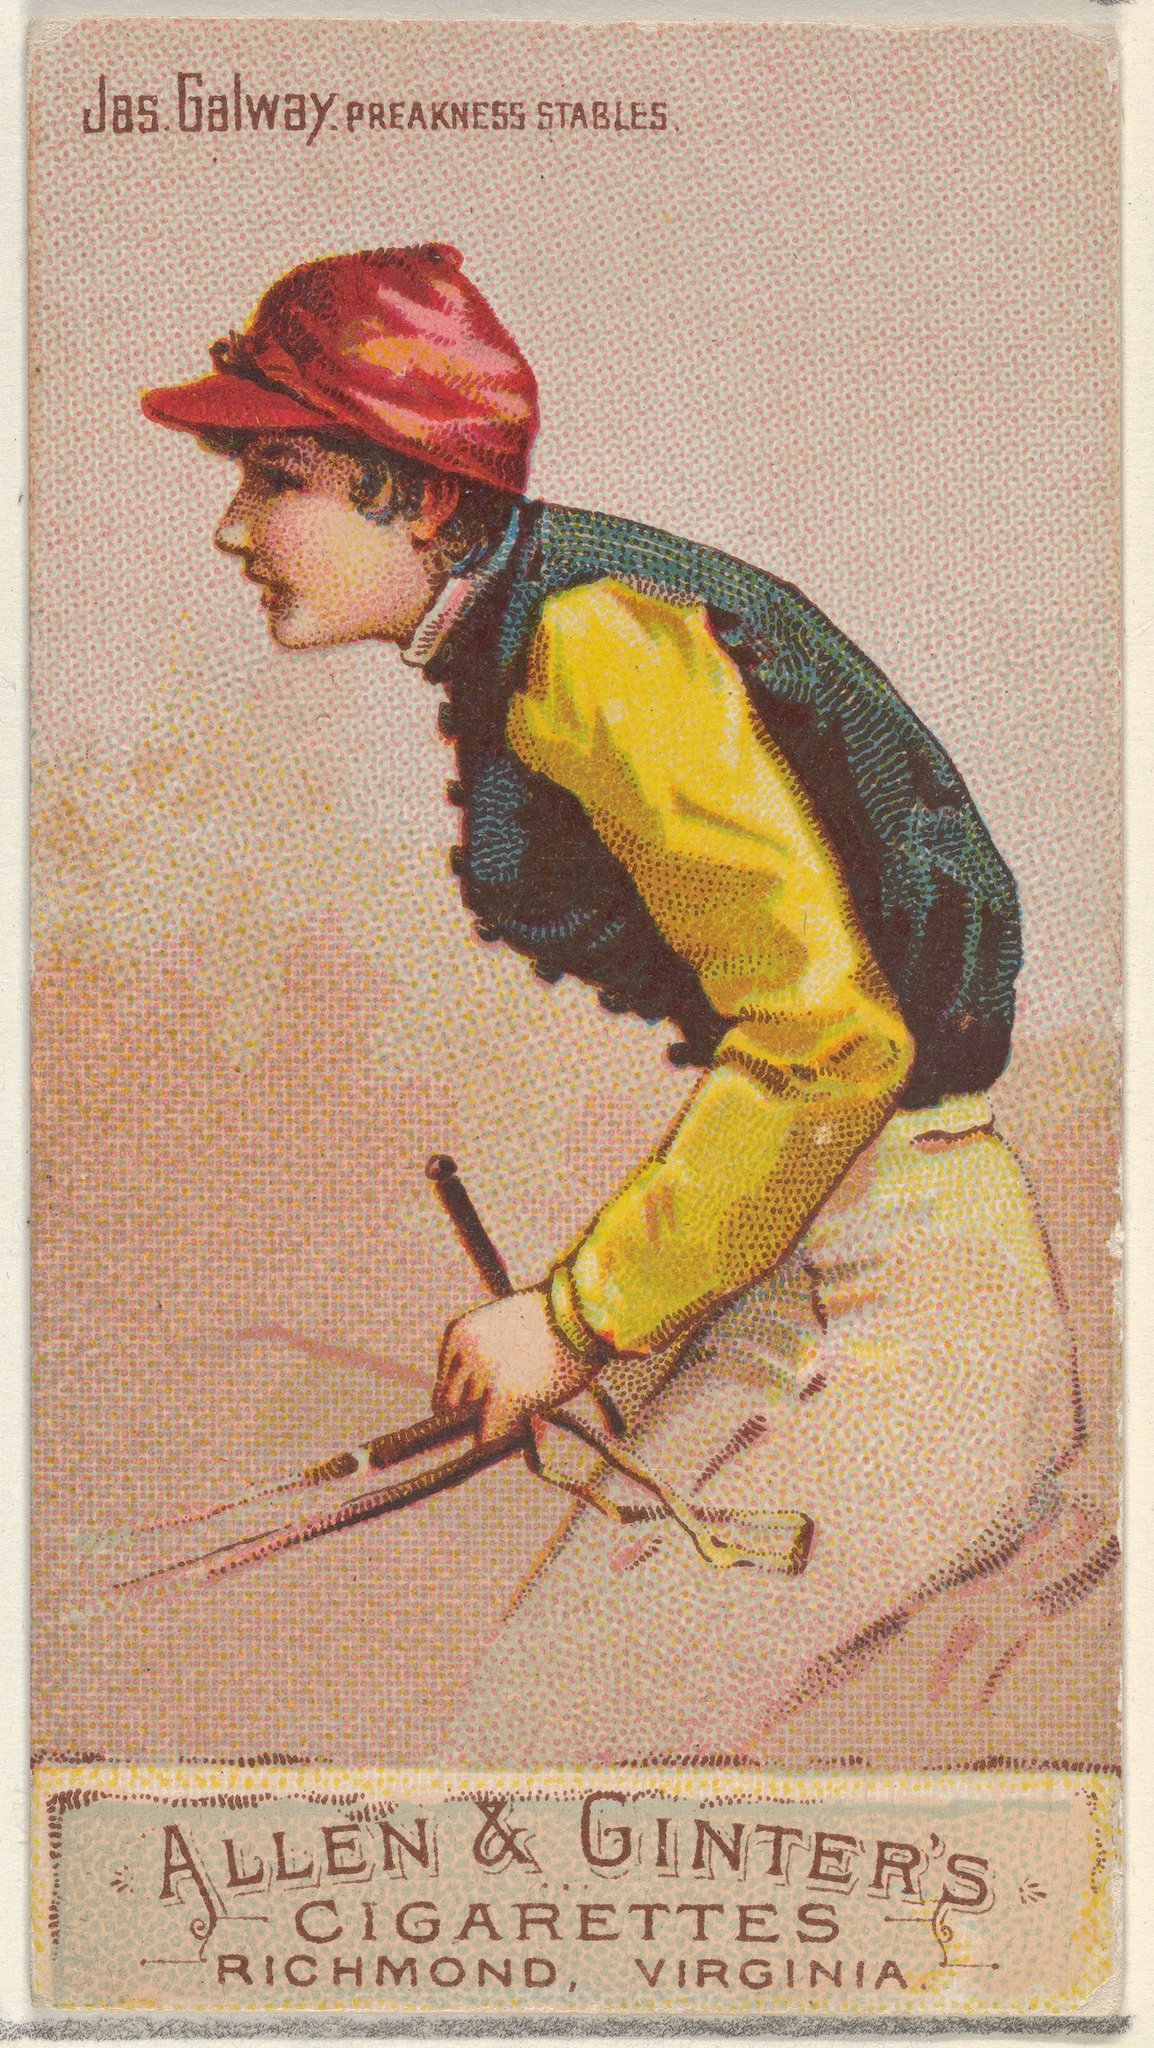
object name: print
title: Jas. Galway, Preakness Stables, from the Racing Colors of the World series (N22b) for Allen & Ginter Cigarettes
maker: allen & ginter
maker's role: publisher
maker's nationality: american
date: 1888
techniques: color lithograph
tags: women,jockeys